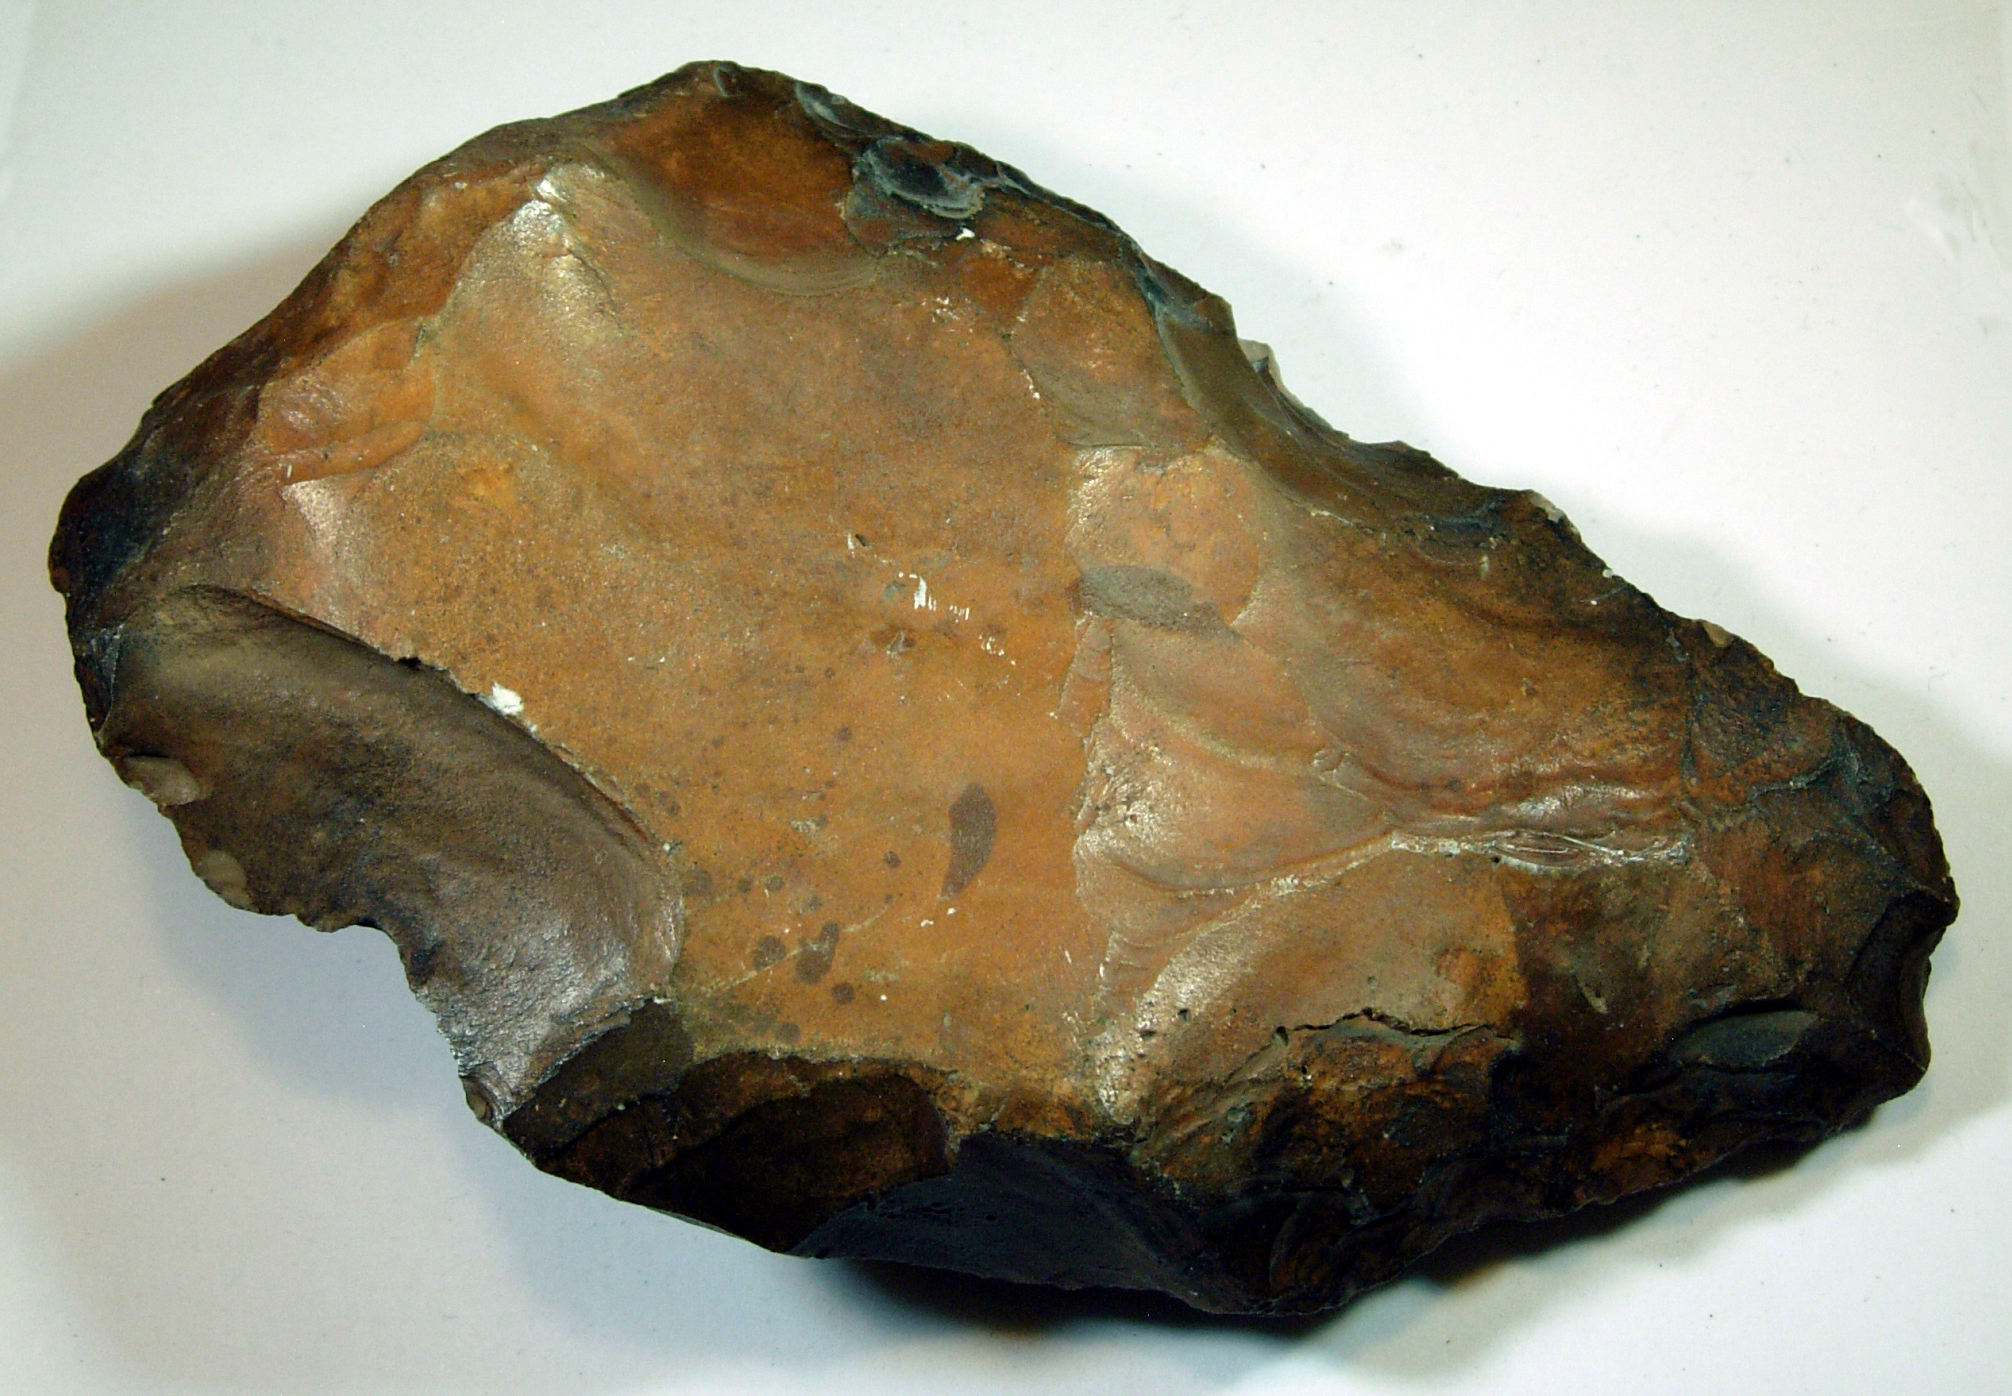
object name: tool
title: Tool (?)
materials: stone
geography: egypt